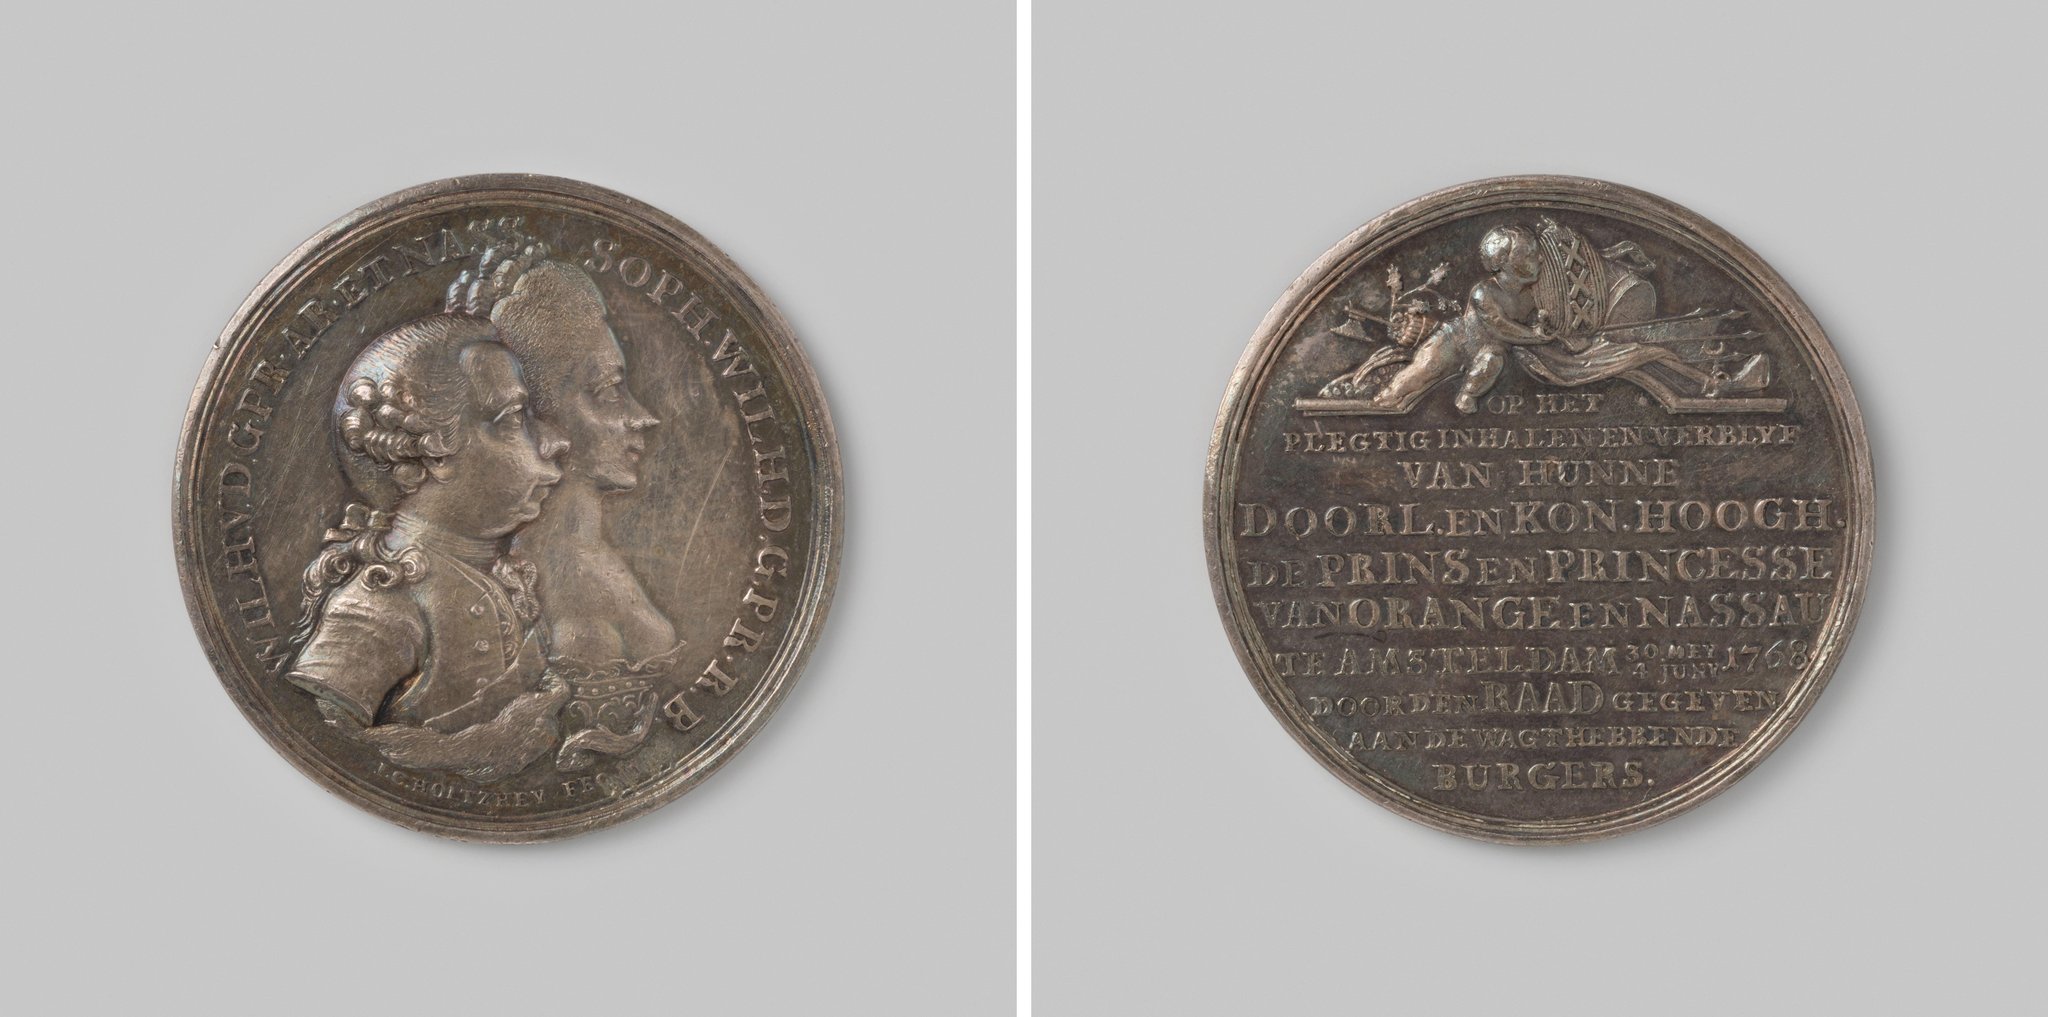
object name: history medal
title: Intocht van Stadhouder Willem V en zijn vrouw in Amsterdam 1768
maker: johan george holtzhey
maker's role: mintmaster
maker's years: 1726-1808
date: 1768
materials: silver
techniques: striking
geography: amsterdam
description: Zilveren penning, op de voorzijde de geconjugeerde borstbeelden van Willem V en zijn vrouw, met omschrift, op de keerzijde tien regels tekst onder een knaapje met het Amsterdamse wapen te midden van schutterij-attributen.